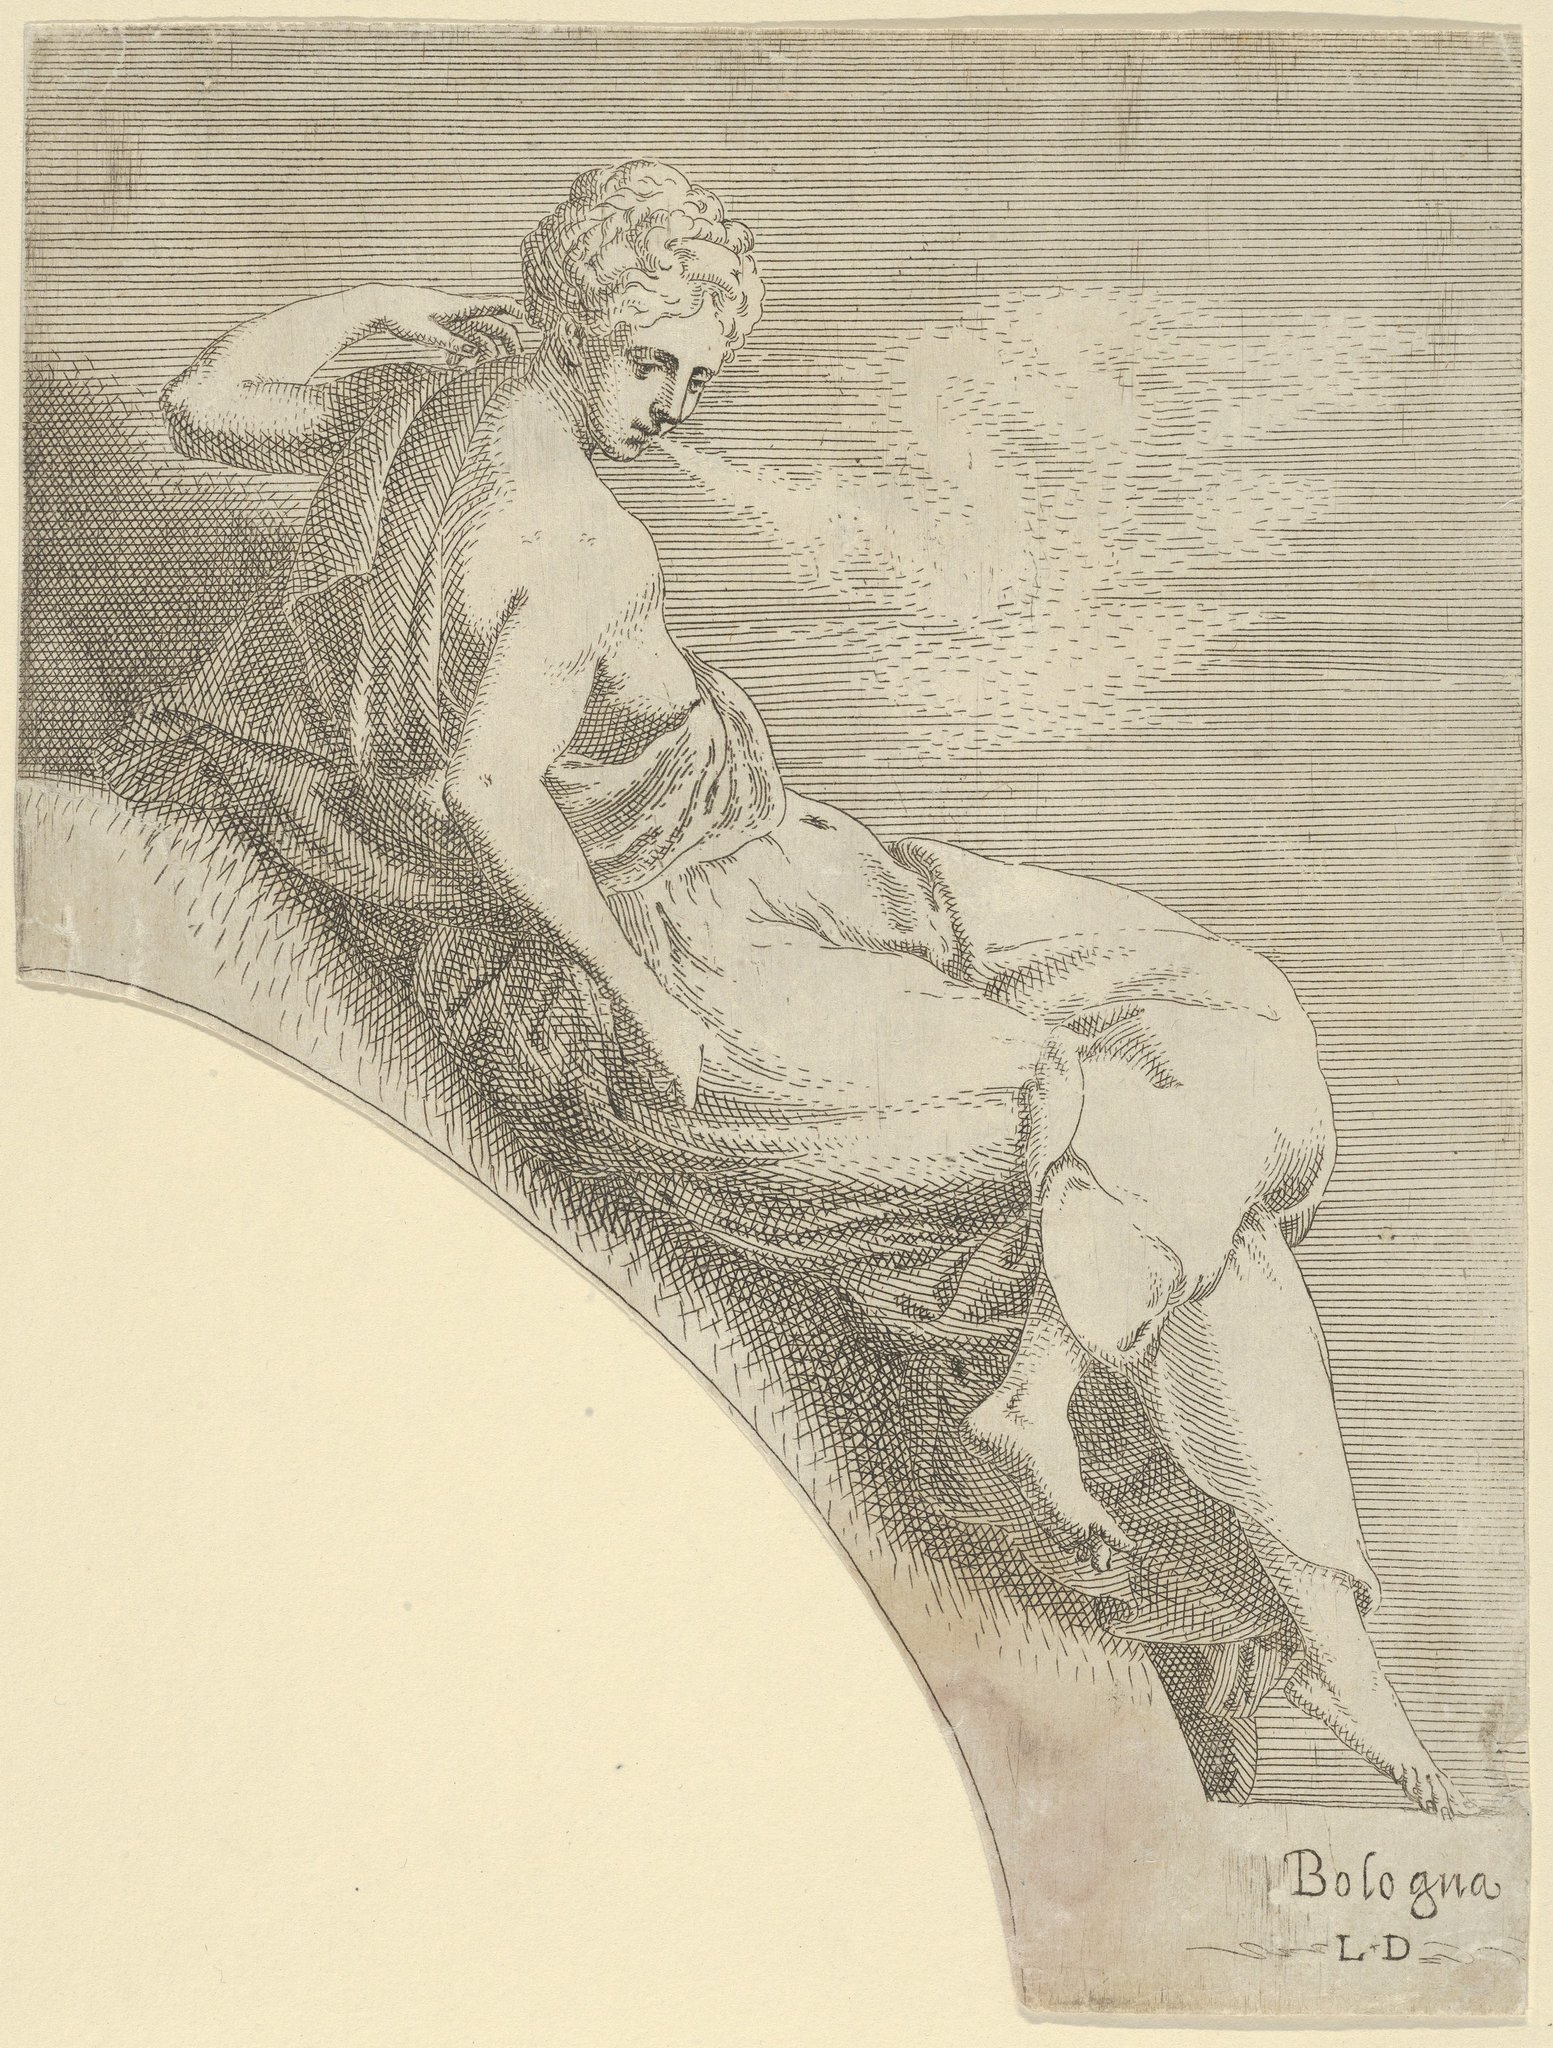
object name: print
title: Polyhymnia, from "Twelve Muses and Goddesses"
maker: léon davent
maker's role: artist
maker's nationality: french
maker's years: 1540-1556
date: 1540-1545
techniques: etching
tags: women,muses